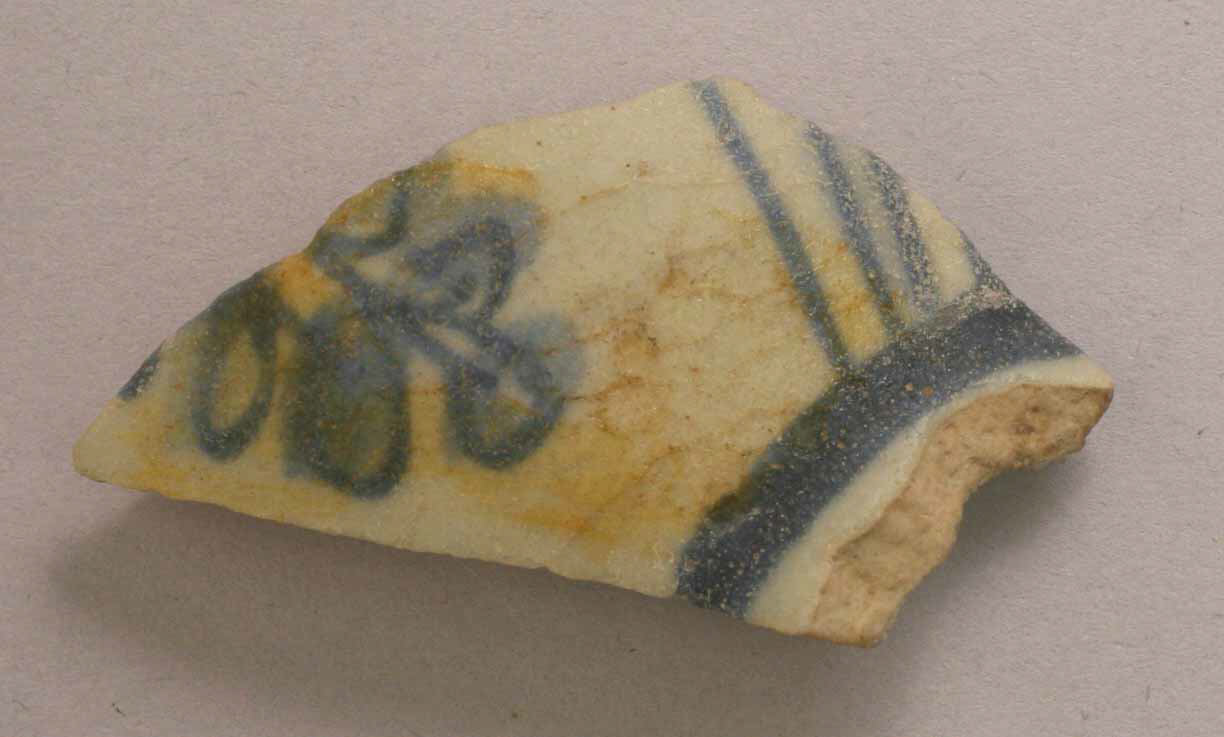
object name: fragment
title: Ceramic Fragment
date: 1201-1400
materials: porcelain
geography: saudi arabia